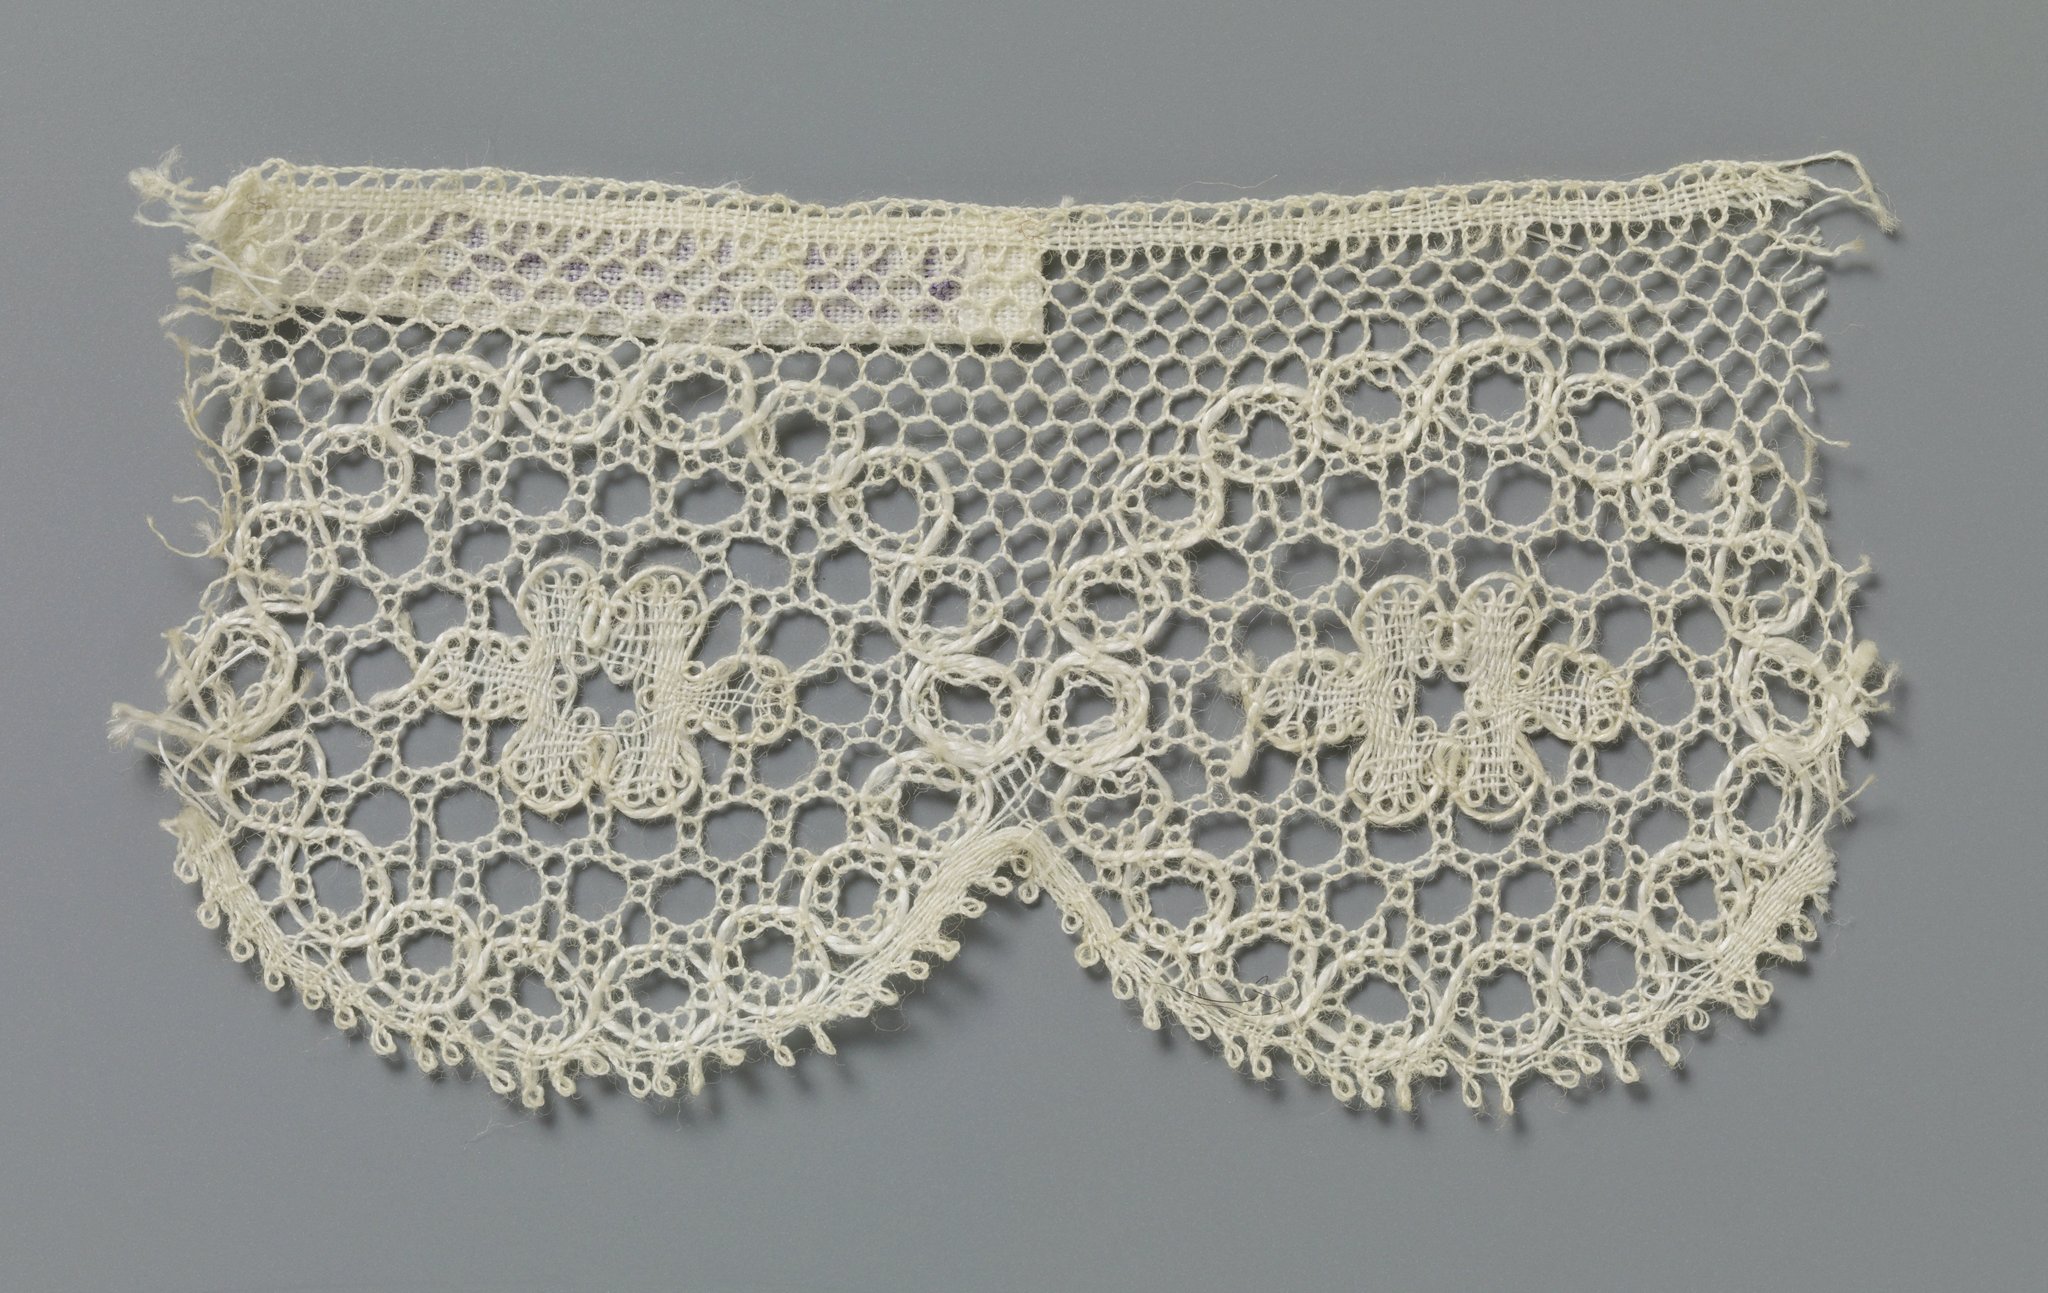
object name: strip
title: Strook kloskant met aaneengeschakelde cirkels met in het centrum een rozetbloem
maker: Anonymous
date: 1800-1899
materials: cotton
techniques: lace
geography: buckingham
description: Strook naturelkleurige kloskant, Buckingham-kant. Het zich herhalende patroon bestaat uit aaneengeschakelde cirkels met in het centrum een rozetbloem. Boven de cirkels loopt een smalle baan gemaakt met een maasgrond, een tulegrond. De cirkels zijn geheel gemaakt met een rozengrond, waarbij de ronde mazen langs de rand zijn geaccentueerd met dikke en glimmende contourdraden. De rozetbloemen zijn gemaakt in linnenslag, met een kleine uitsparing in het midden en langs de buitenkant voorzien van een contourdraad. Elke cirkel vormt een halfronde schulp aan de onderzijde van de strook en is afgewerkt met picots. De bovenzijde van de strook is recht afgewerkt.